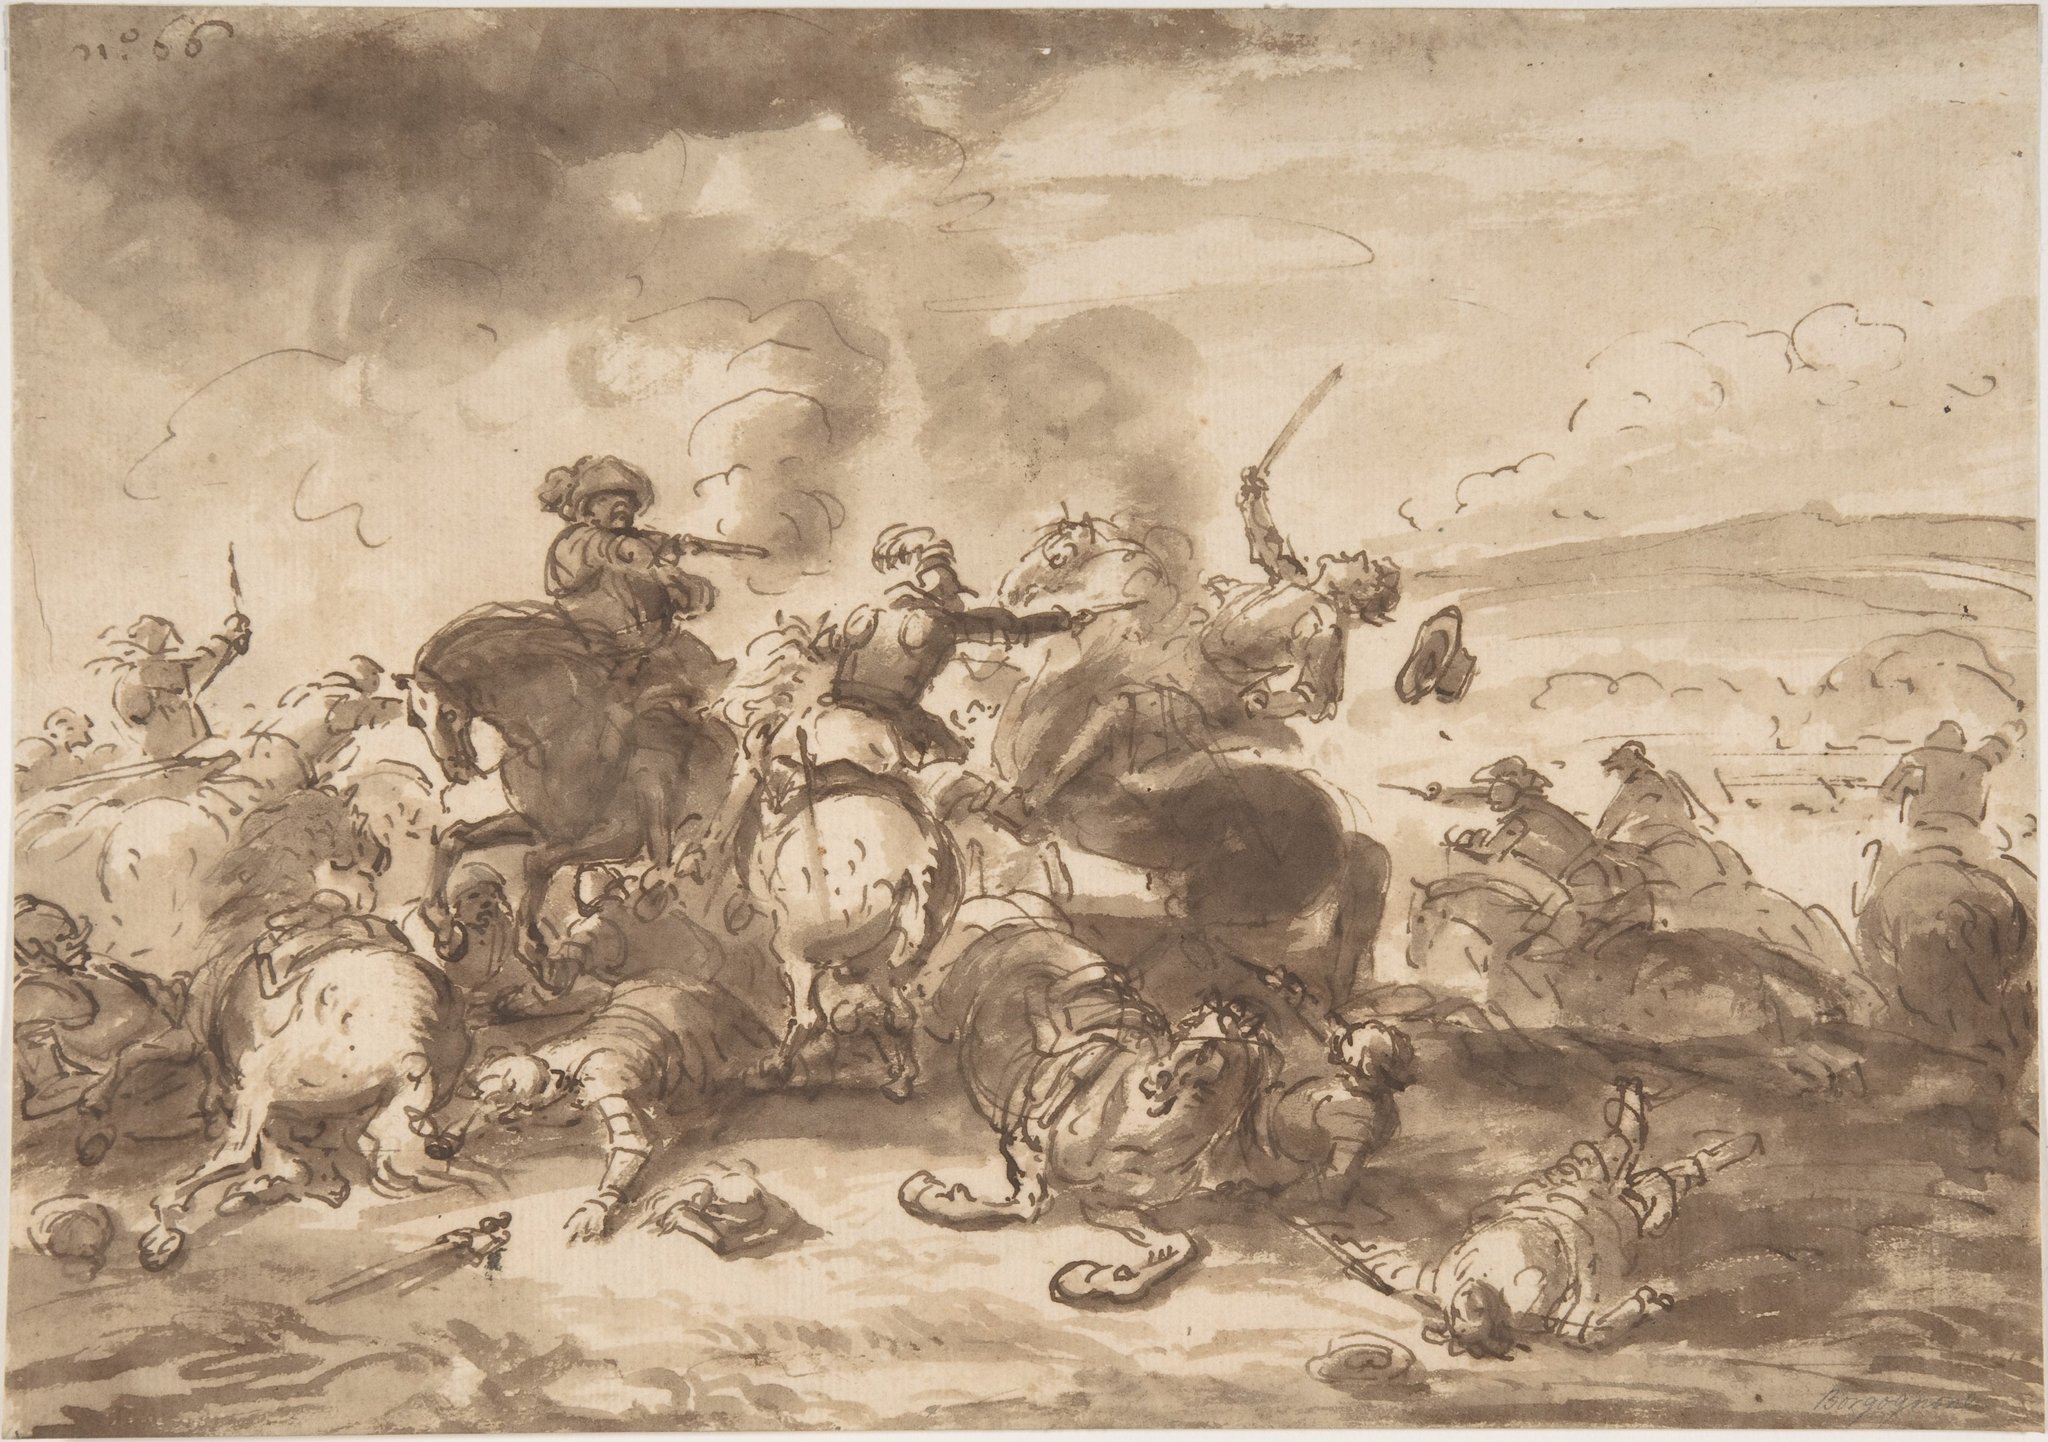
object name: drawing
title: Combat of Cavalry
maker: jacques courtois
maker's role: artist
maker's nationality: french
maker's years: 1621-1676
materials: paper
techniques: pen, wash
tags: battles,men,horses